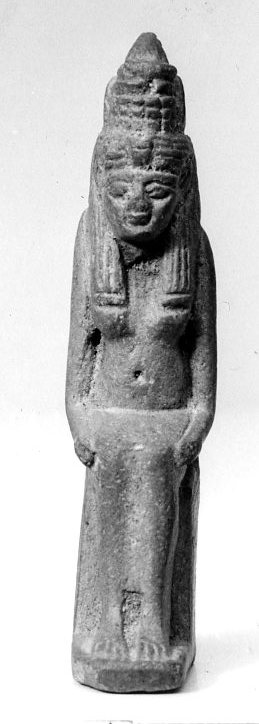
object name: amulet, hatmehyt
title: Amulet of the goddess Hatmehyt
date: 664-630 BCE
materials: faience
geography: egypt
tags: goddess